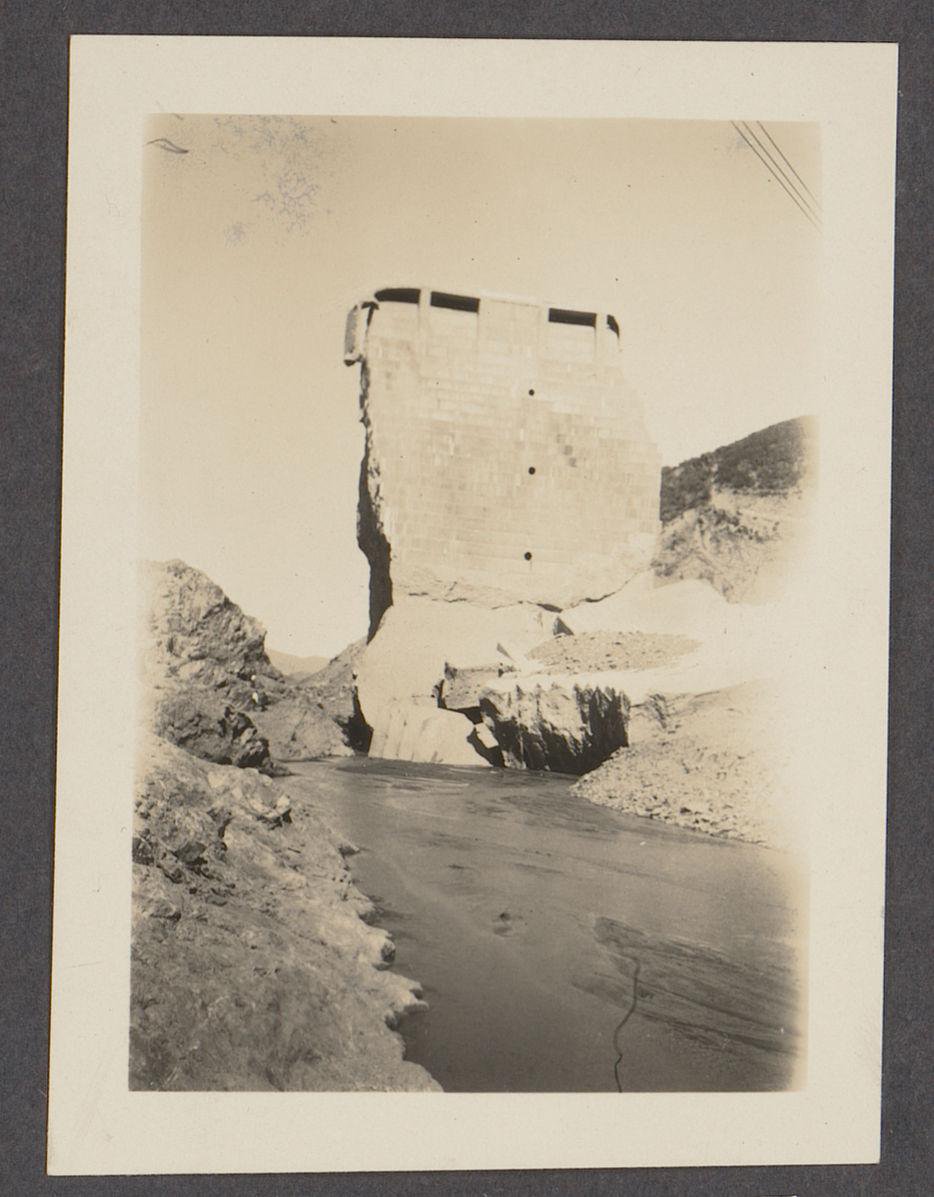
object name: photograph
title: Saint Francisdam te Los Angeles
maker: Anonymous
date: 1928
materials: photographic support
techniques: gelatin silver print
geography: los angeles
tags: dam (in canal)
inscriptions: annotation: ‘St. Francis dam’